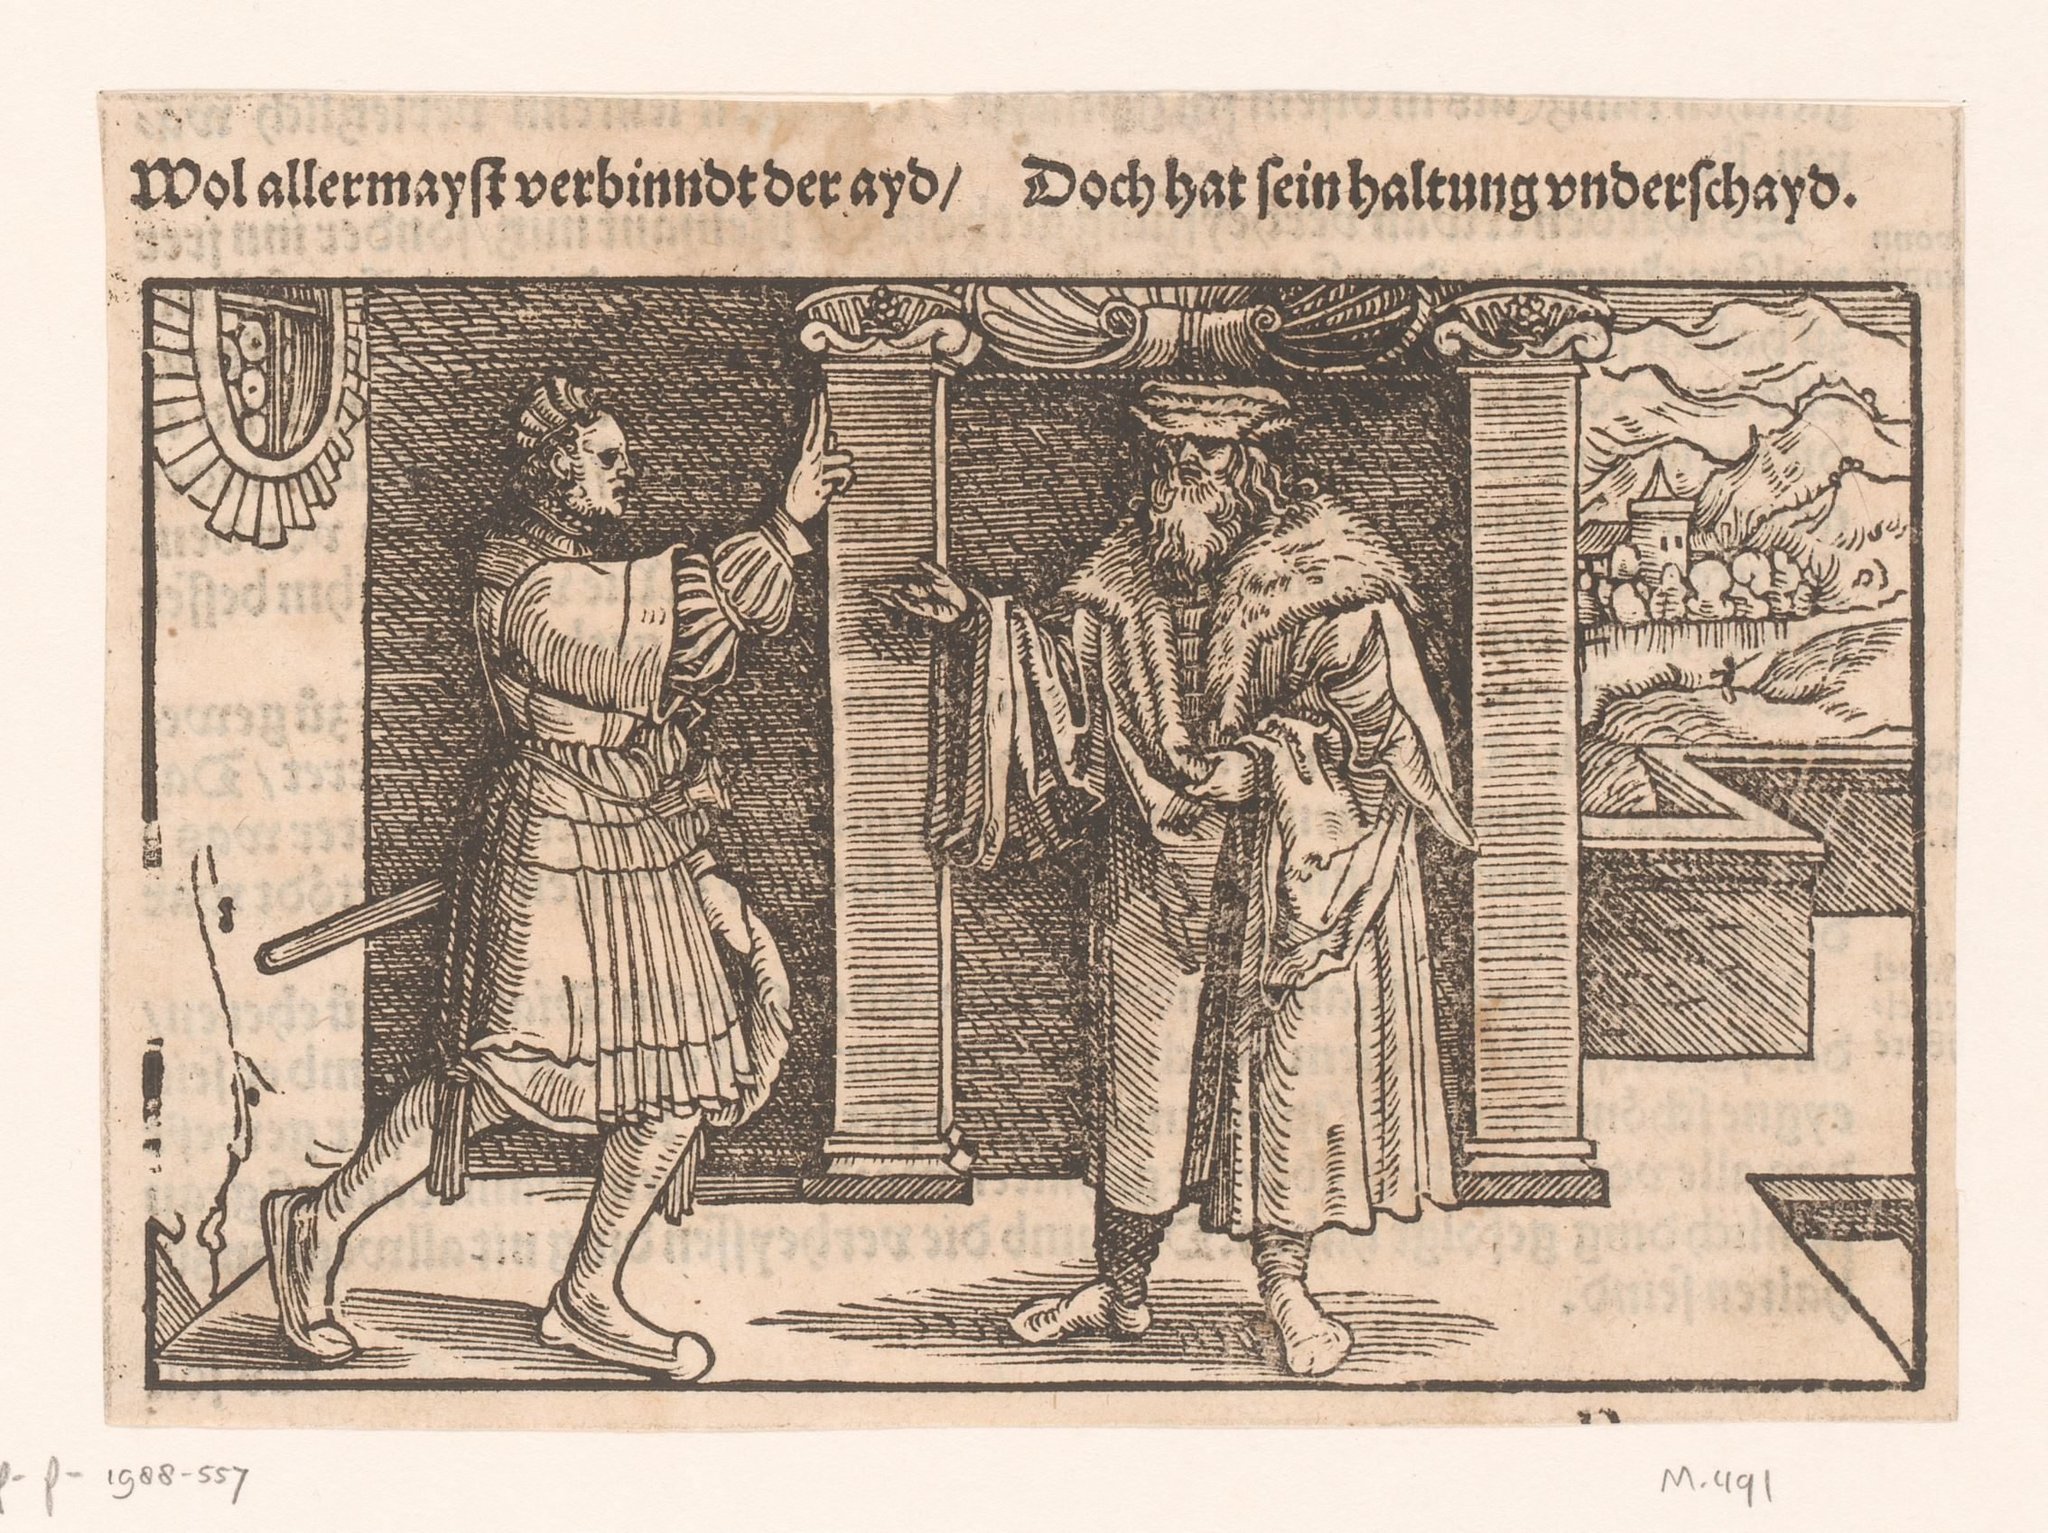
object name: book illustration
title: Man legt een eed af aan een ander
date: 1531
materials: paper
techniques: woodcut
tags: new ruler taking the oath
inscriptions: collector's mark: Lugt 2228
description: Prent voor het eerst gebruikt in: Cicero, Marcus Tullius. Officia M.T.C. Ein Buch So Marcus Tullius Cicero (...). Augsburg: Heinrich Steiner, 1531.